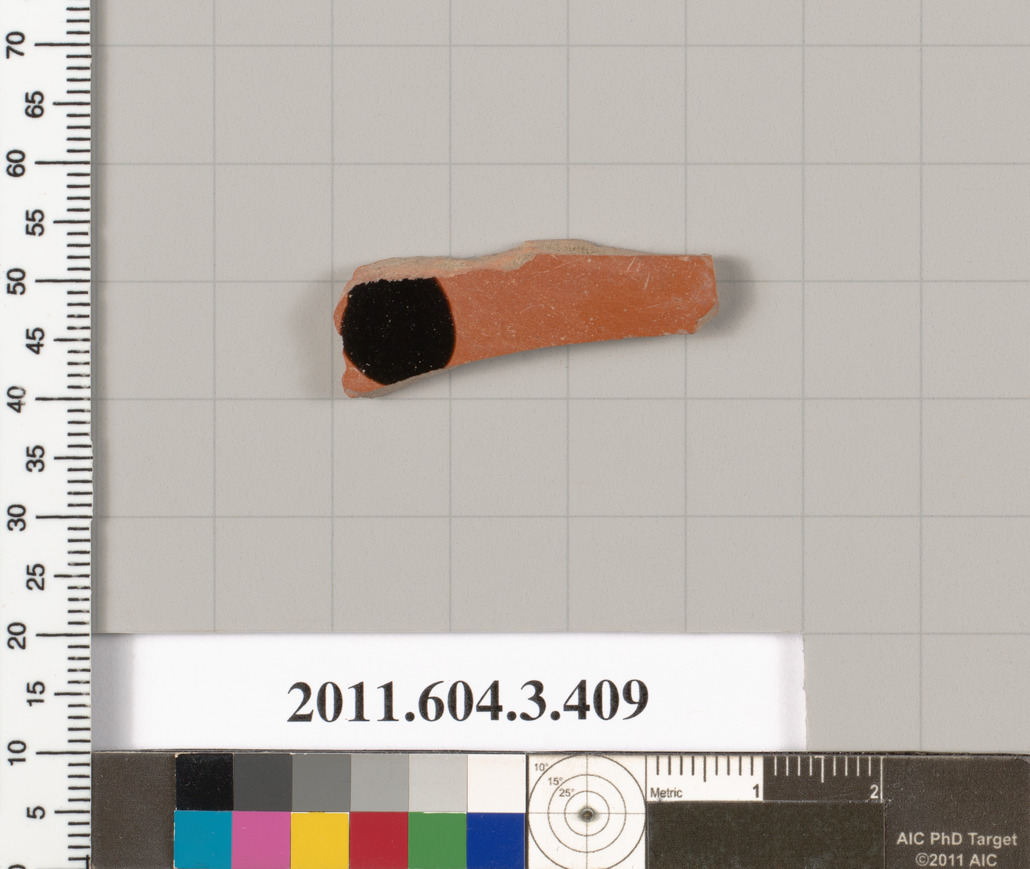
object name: neck amphora fragment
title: Terracotta fragment of a neck-amphora (jar)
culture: greek, attic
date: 500-468 BCE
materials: terracotta